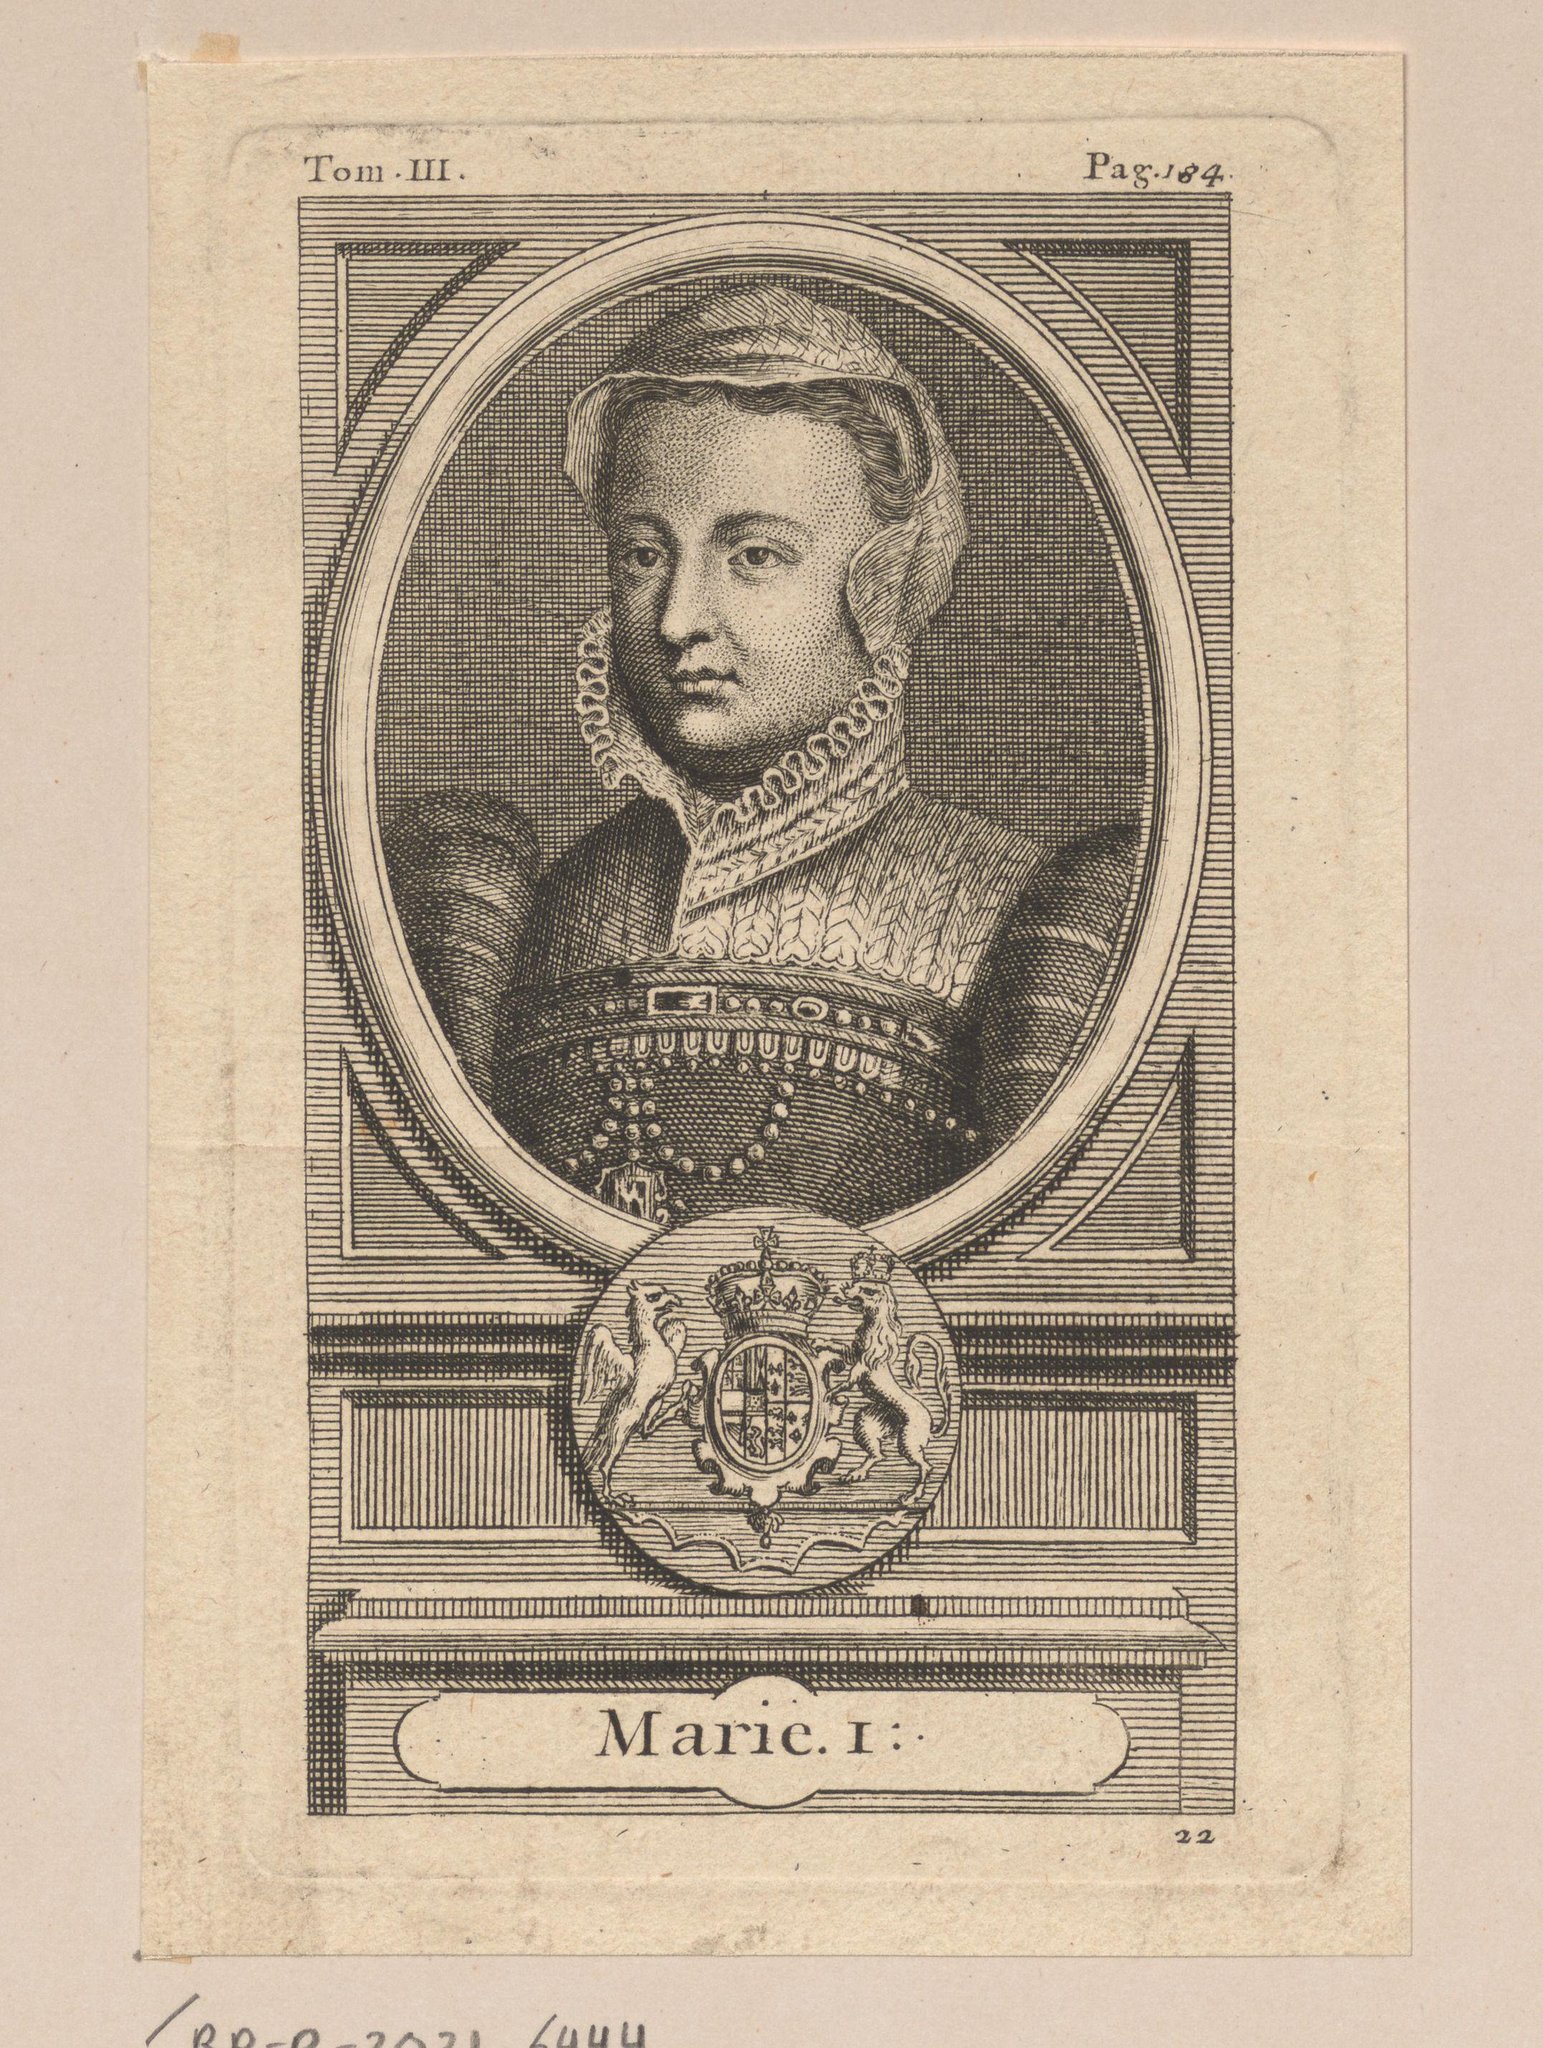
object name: book illustration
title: Portret van Maria I van Engeland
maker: Anonymous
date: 1750-1762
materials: paper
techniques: engraving, etching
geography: france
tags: london, historical persons - bb - woman, ornament ~ medallion, queen, armorial bearing, heraldry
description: Prent waarschijnlijk uit: Orleans, Pierre Joseph d’. Histoire des revolutions d'Angleterre, depuis le commencement de la monarchie. Parijs: Pierre-François Giffart en Jacques Rolin, 1750, dl. 3, p. 184. Prent ook gebruikt in de 1762-editie uitgegeven in Lyon door de gebroeders Duplain. Mogelijk ook gebruikt in andere edities of andere publicaties.